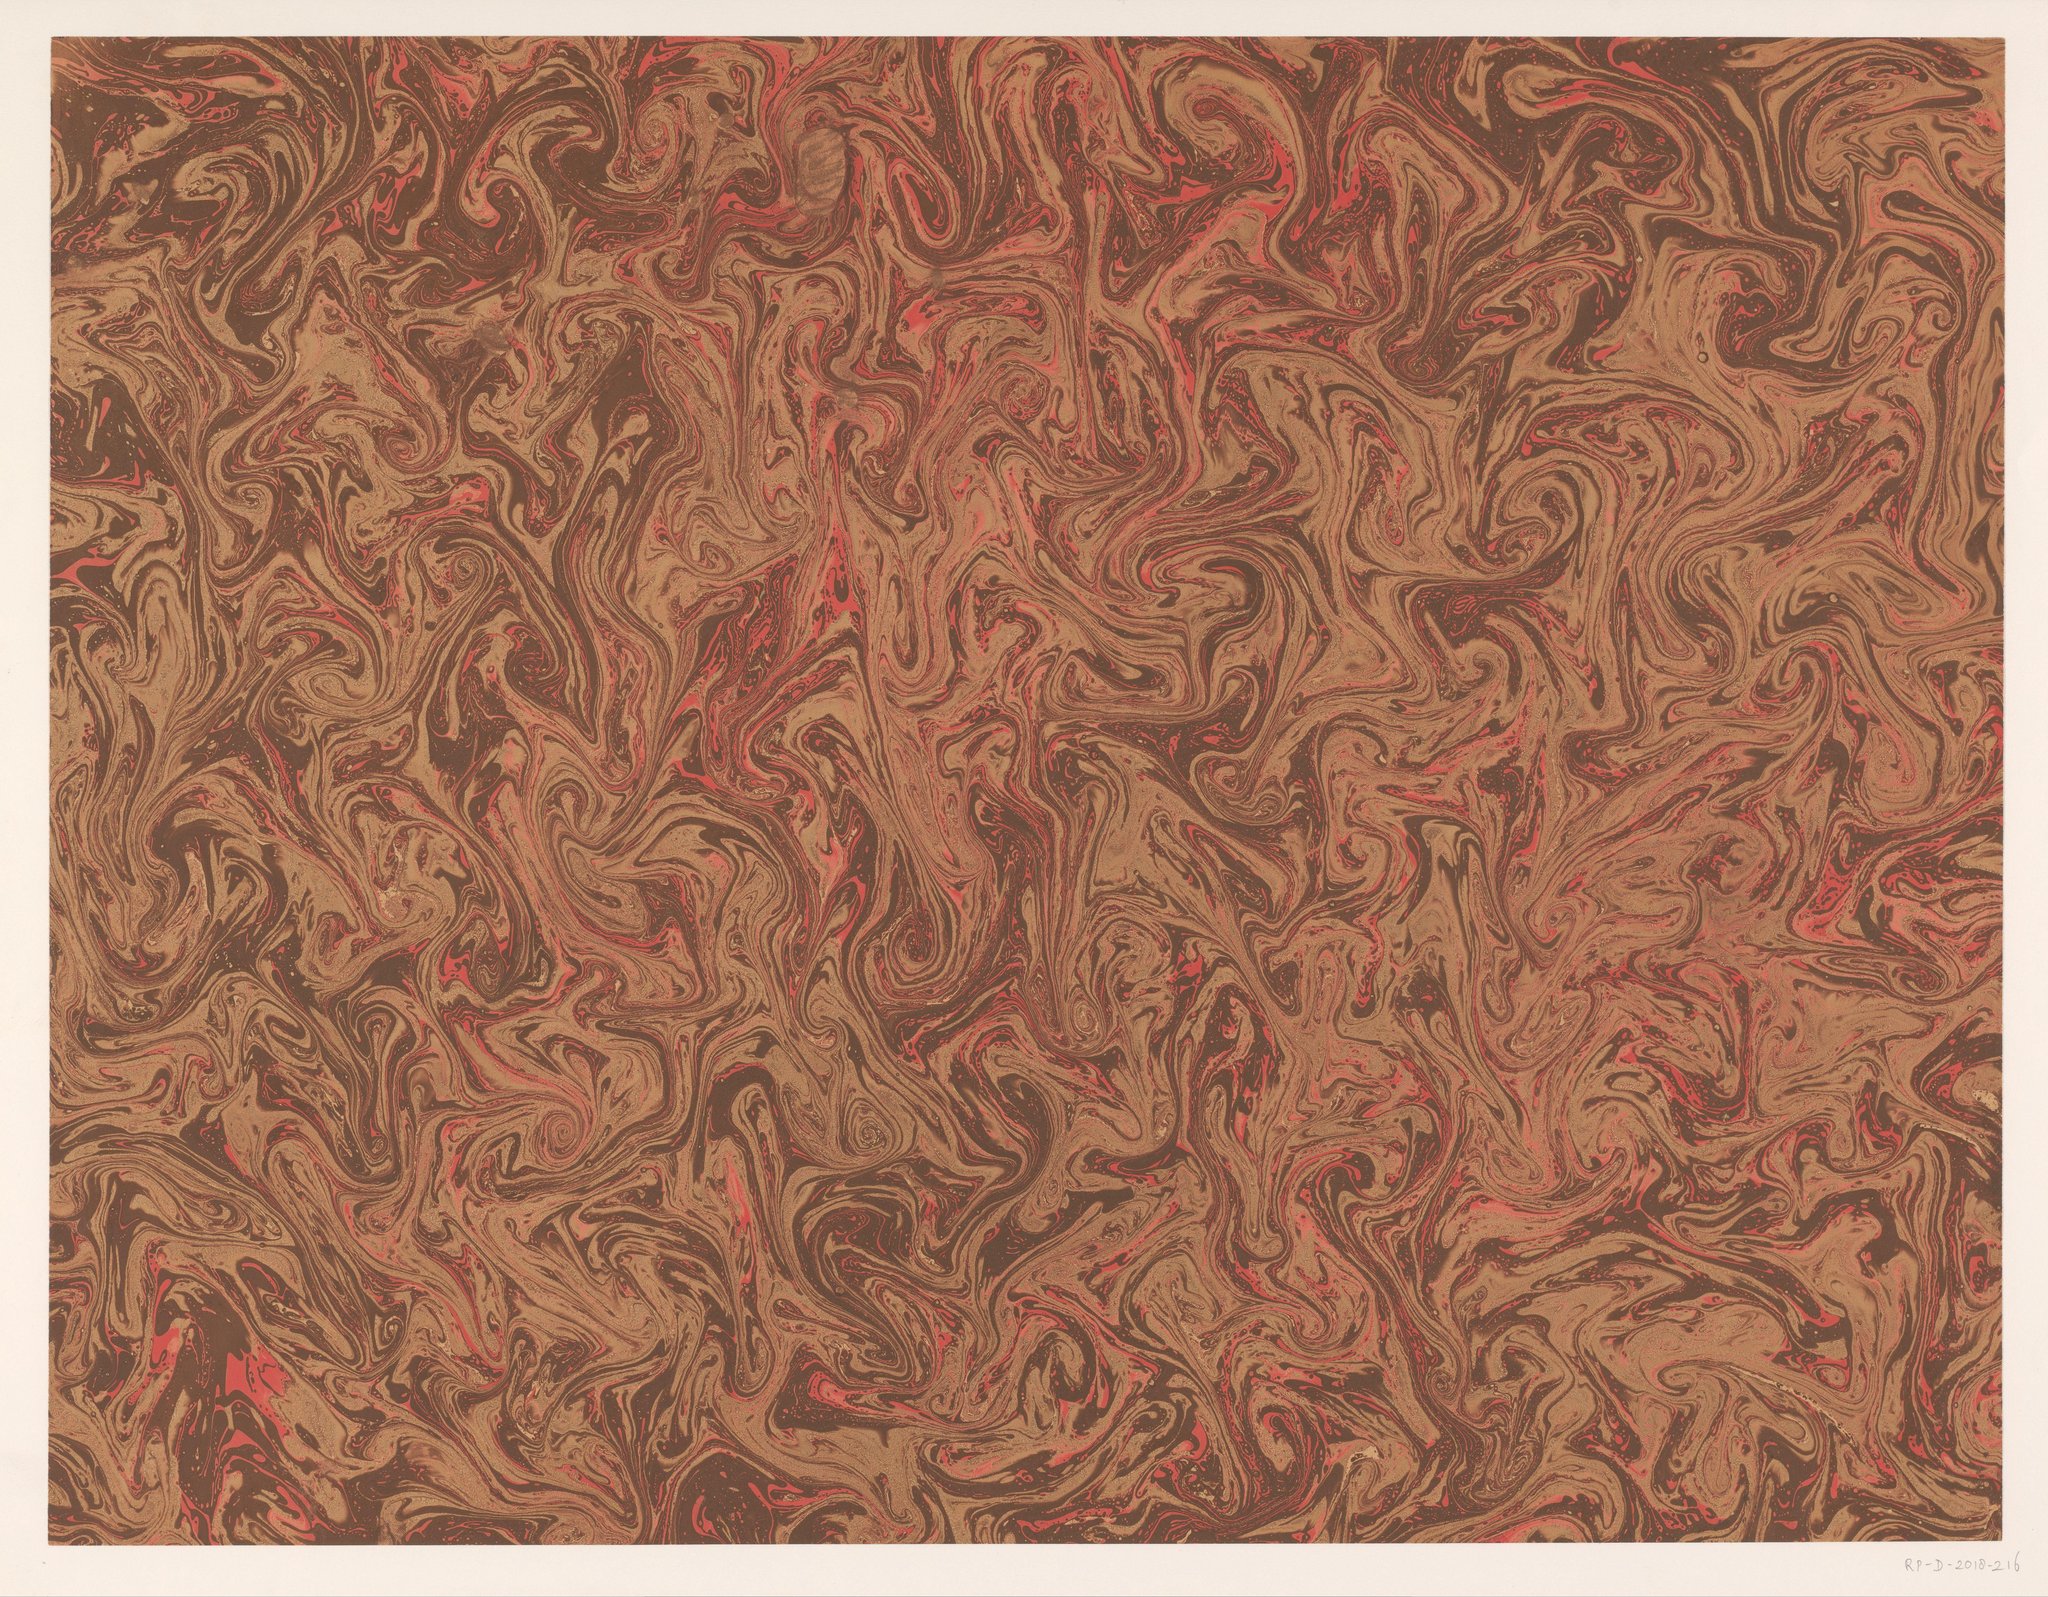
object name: marbled paper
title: Fantasiemarmer in verschillende tinten bruin en rood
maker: Anonymous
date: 1900-2000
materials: paint, paper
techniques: marbled paper